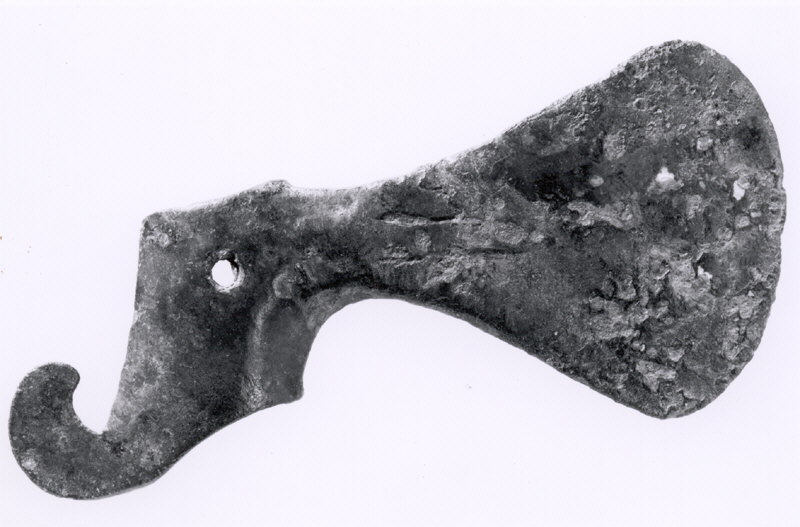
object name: axe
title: Shaft-hole axe head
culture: bactria-margiana archaeological complex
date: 2333-1668 BCE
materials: copper alloy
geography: bactria-margiana